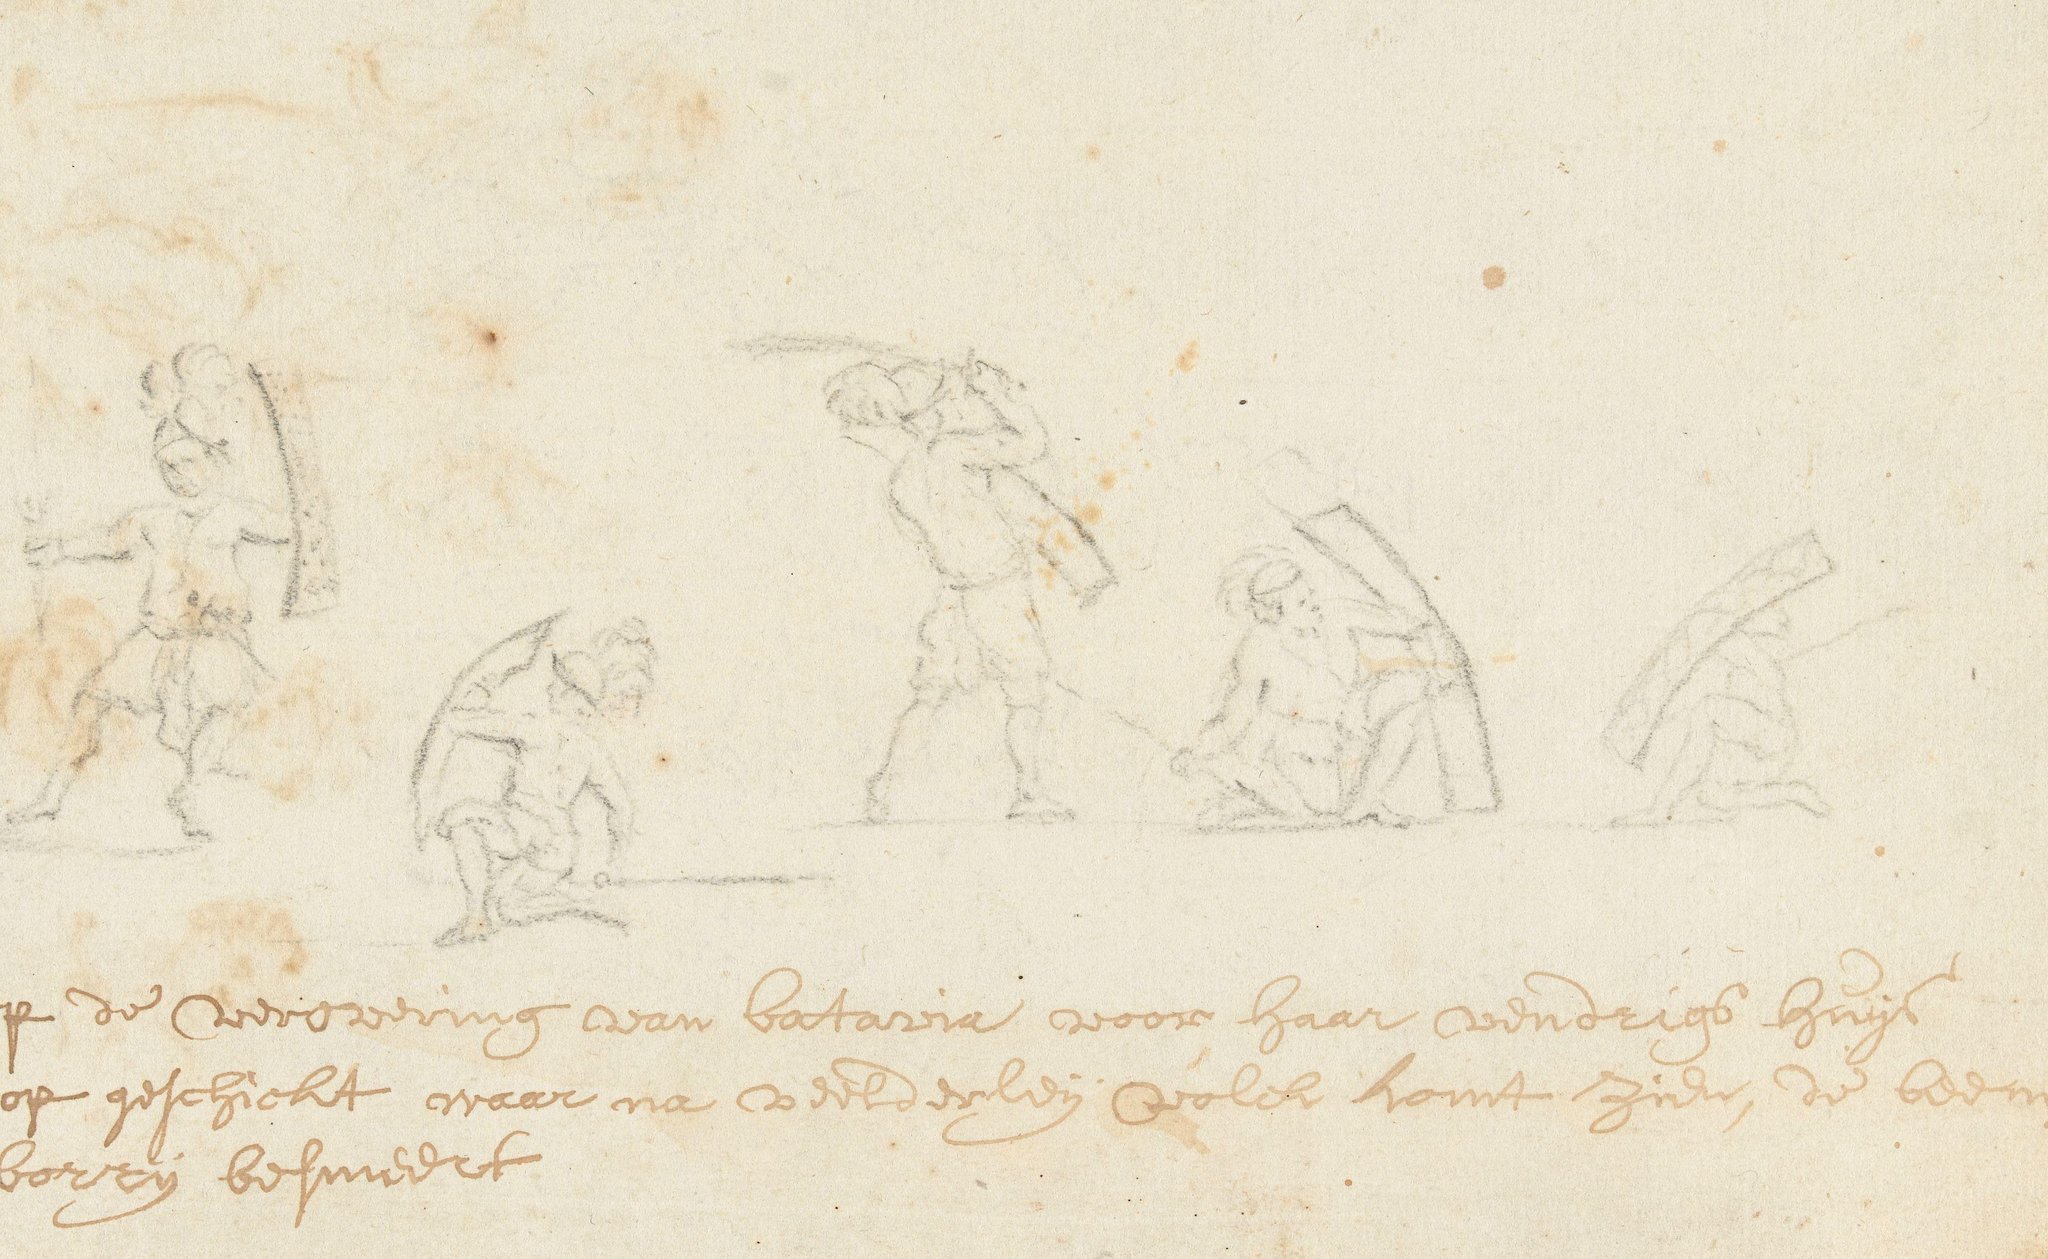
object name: drawing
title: Reisschetsen gemaakt in Indië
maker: wouter schouten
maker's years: 1638-1704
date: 1660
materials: paper, pencil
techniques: drawing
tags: batavia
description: Krijgers met schilden, een man met een musket en een opschrift.